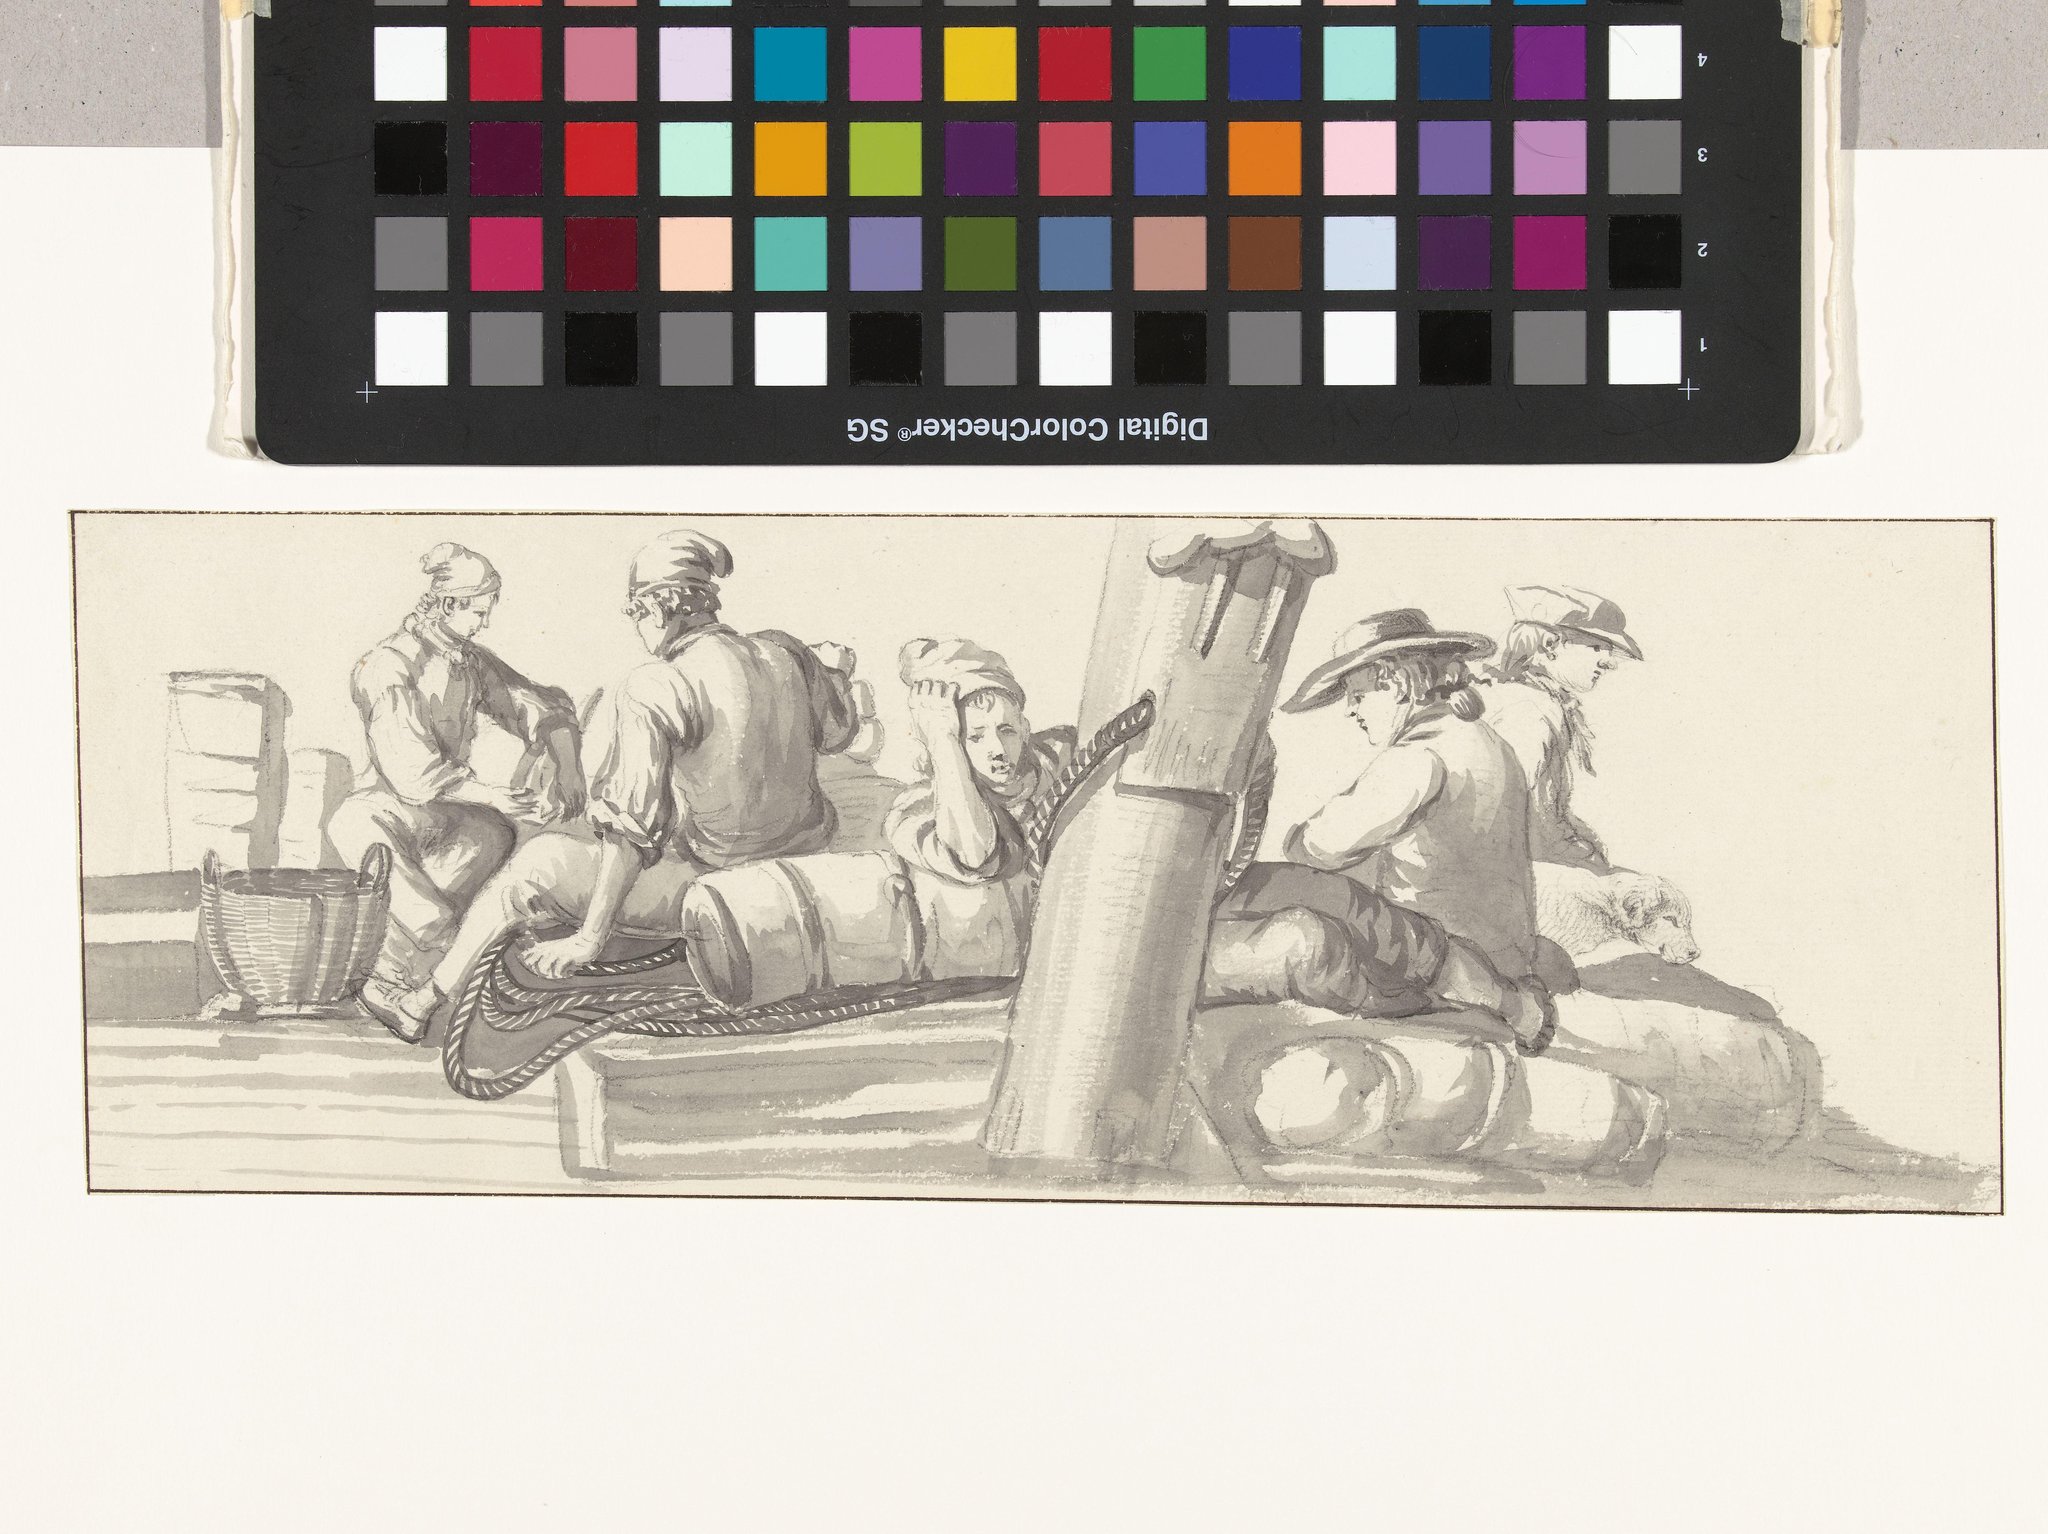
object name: drawing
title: Domestiques & Mariniers à bord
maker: louis ducros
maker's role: draughtsman, print maker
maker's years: 1748-1810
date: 1778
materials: chalk, paper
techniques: brush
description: Tekening uit het album 'Voyage en Italie, en Sicile et à Malte', 1778.